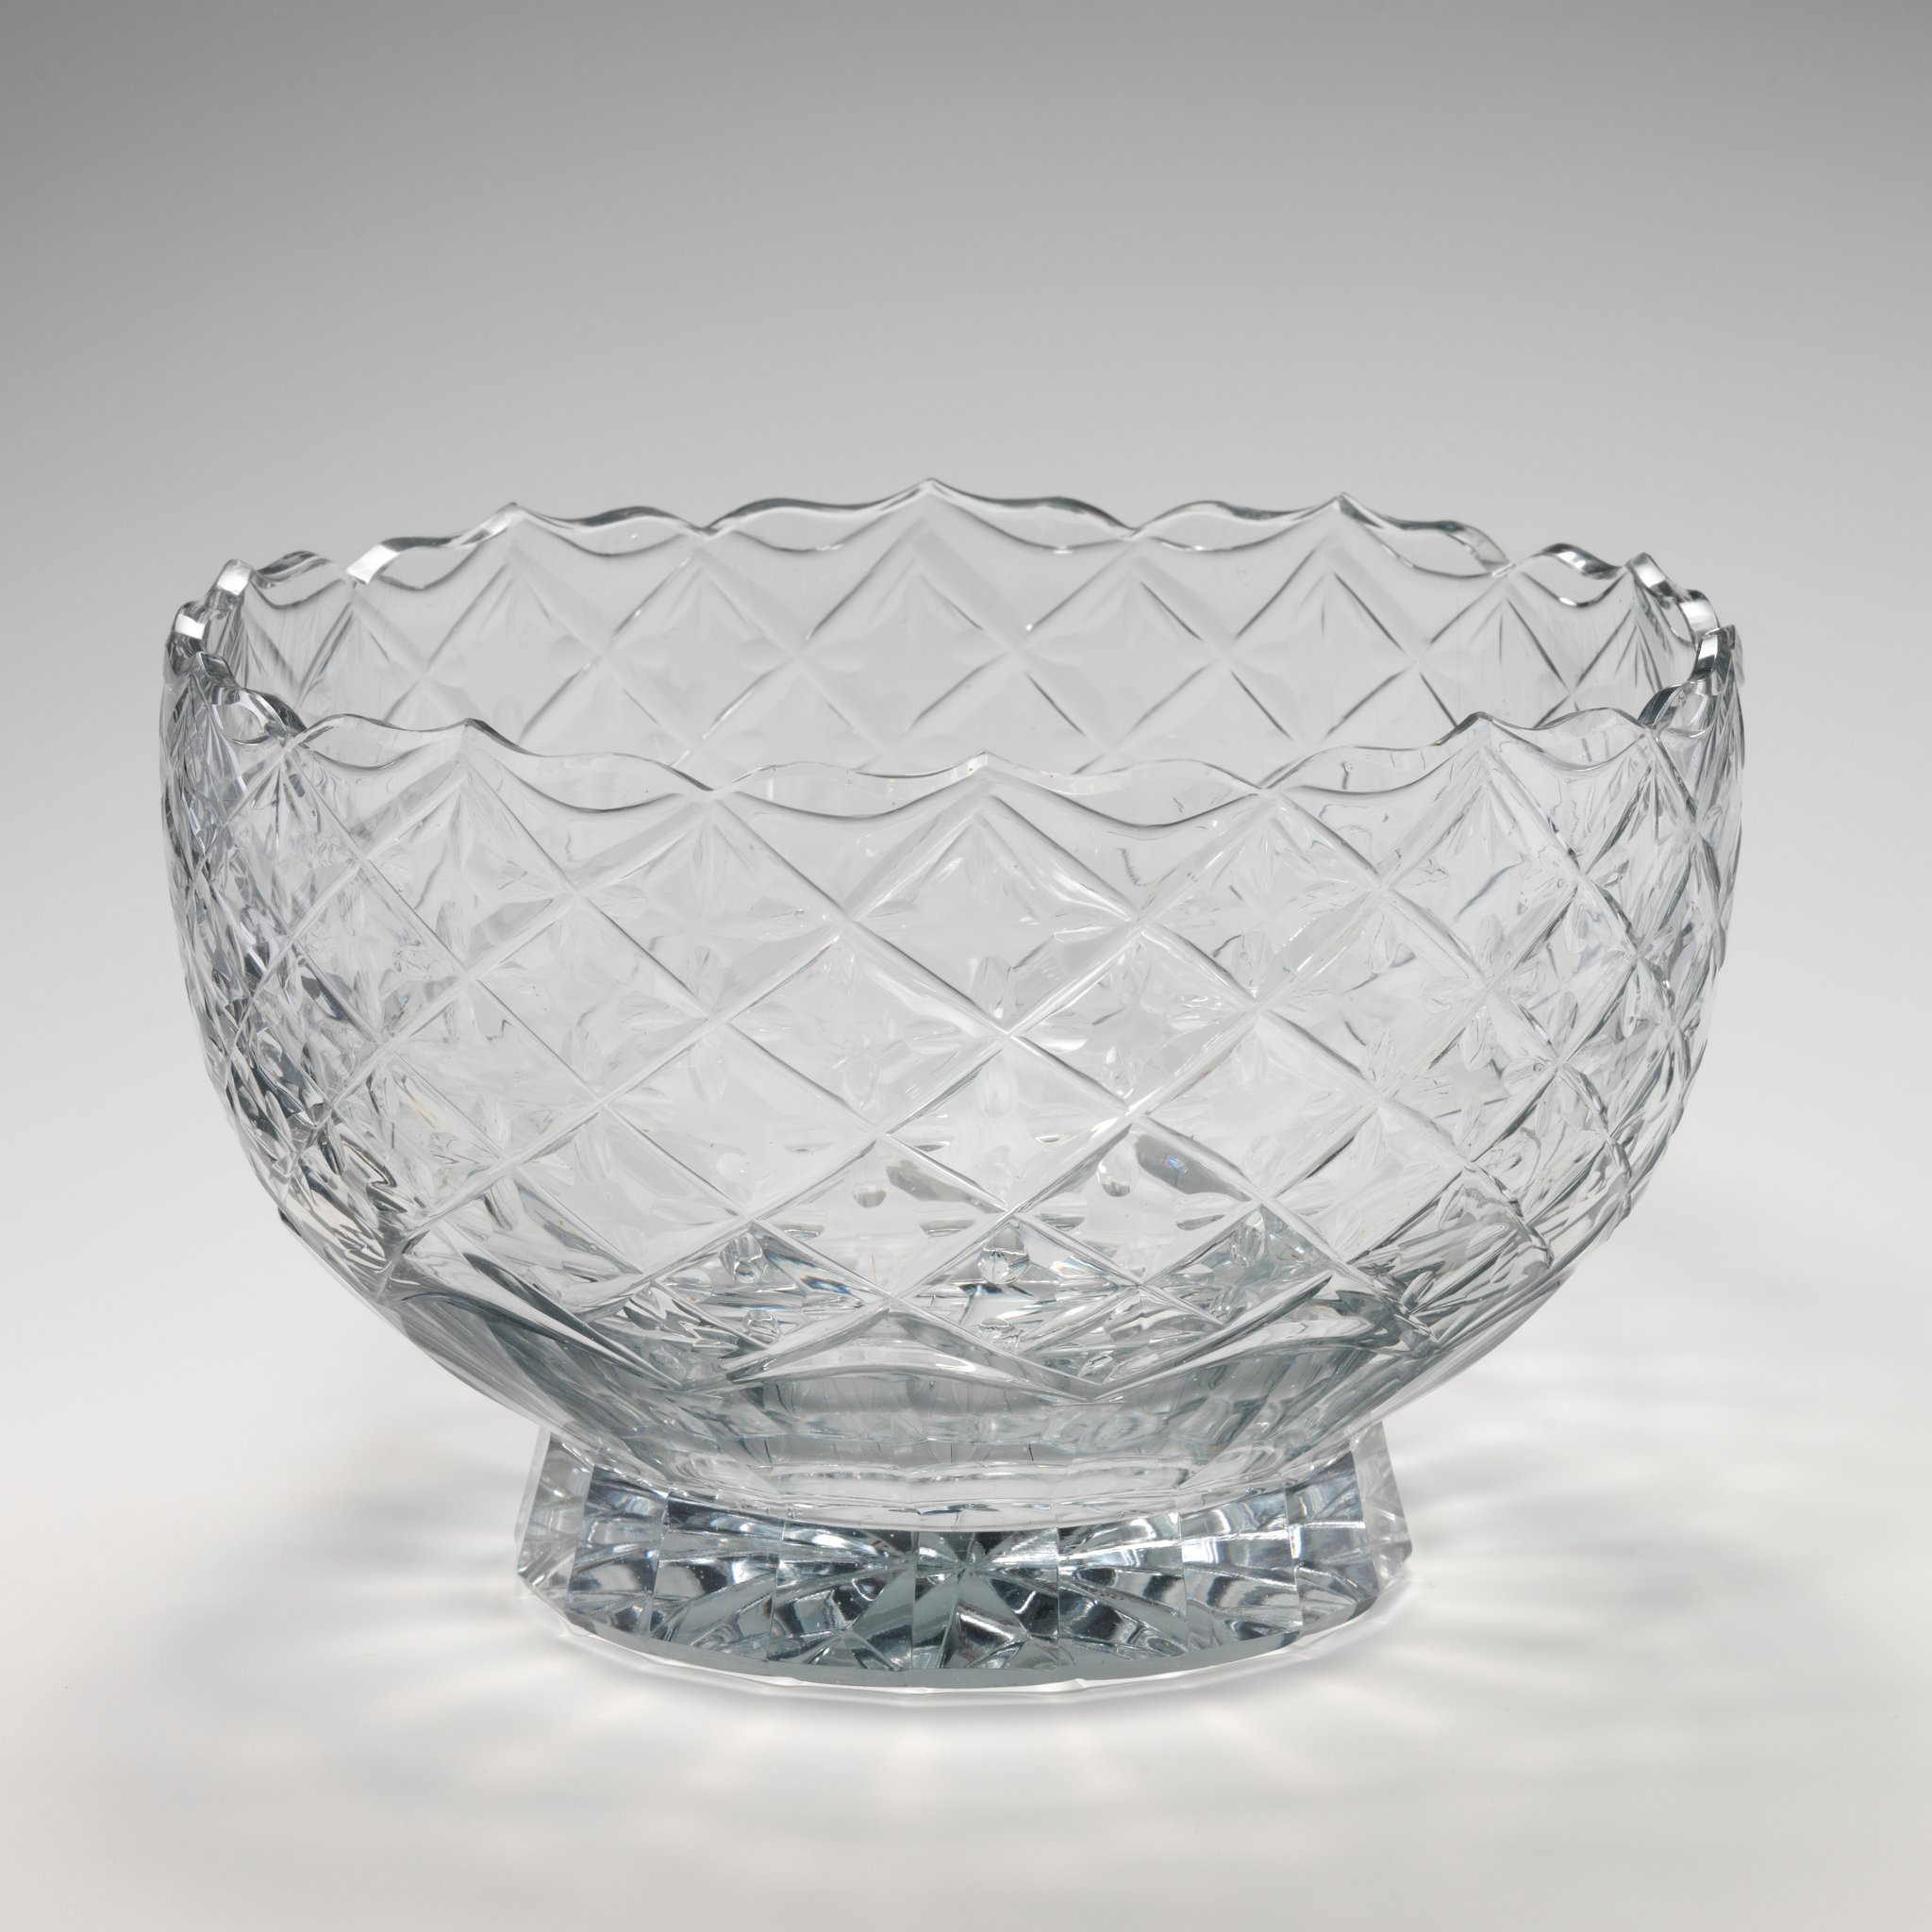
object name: bowl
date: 1767-1833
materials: glass